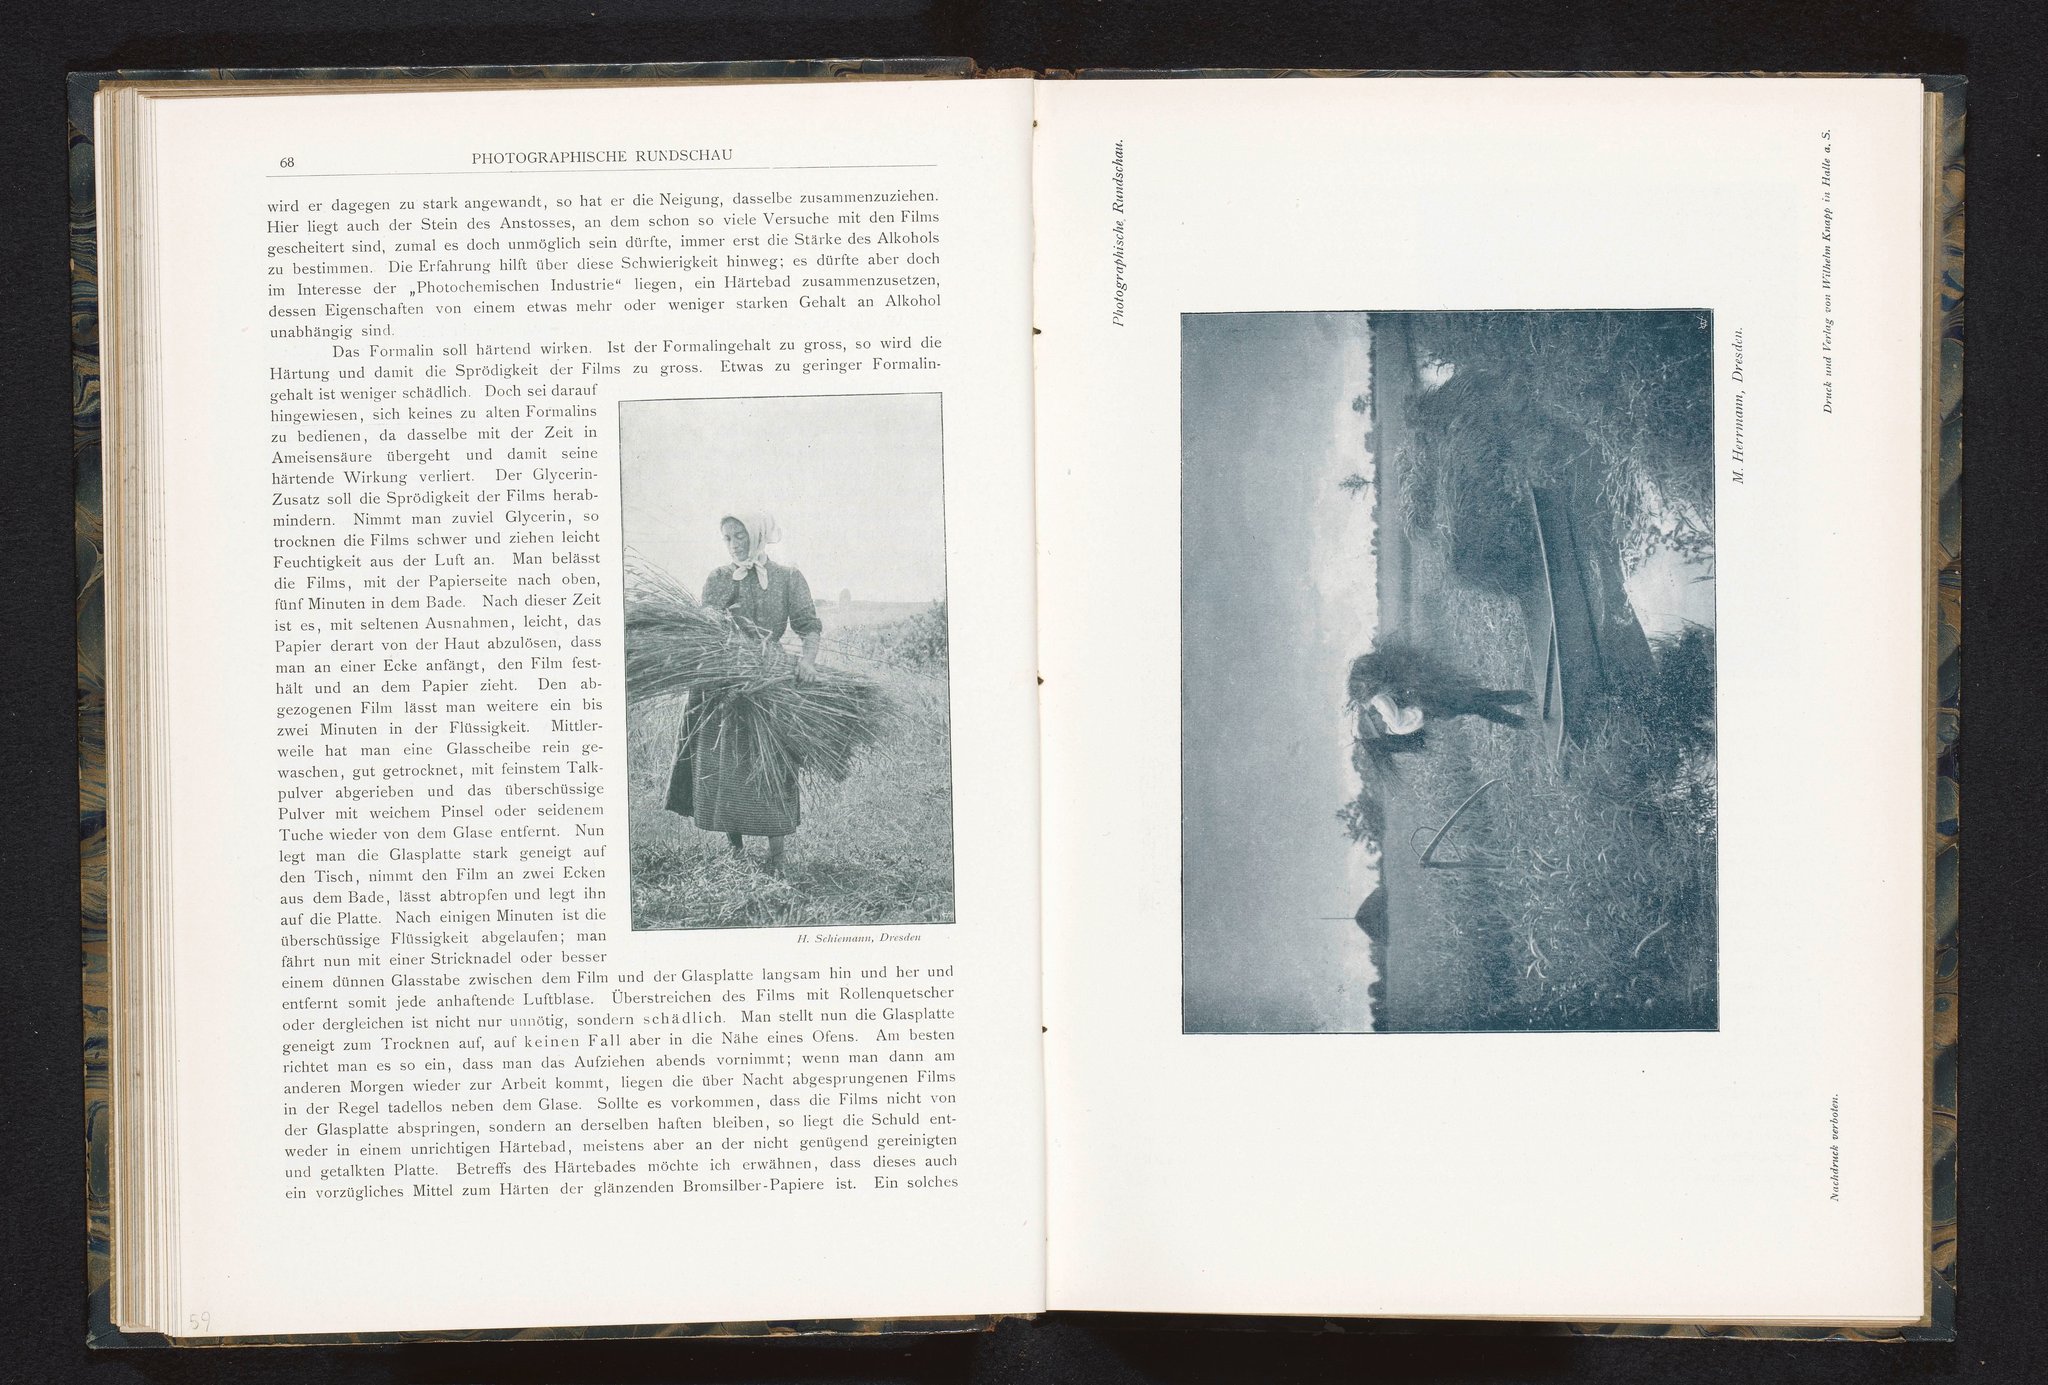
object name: photomechanical print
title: Gezicht op een onbekende man die een boot vollaadt met stro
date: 1895-1900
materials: paper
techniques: autotype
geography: halle an der saale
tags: agricultural products and by-products: straw, adult man, meadow, pasture, small canal, ditch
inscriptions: monogram: ‘WC’